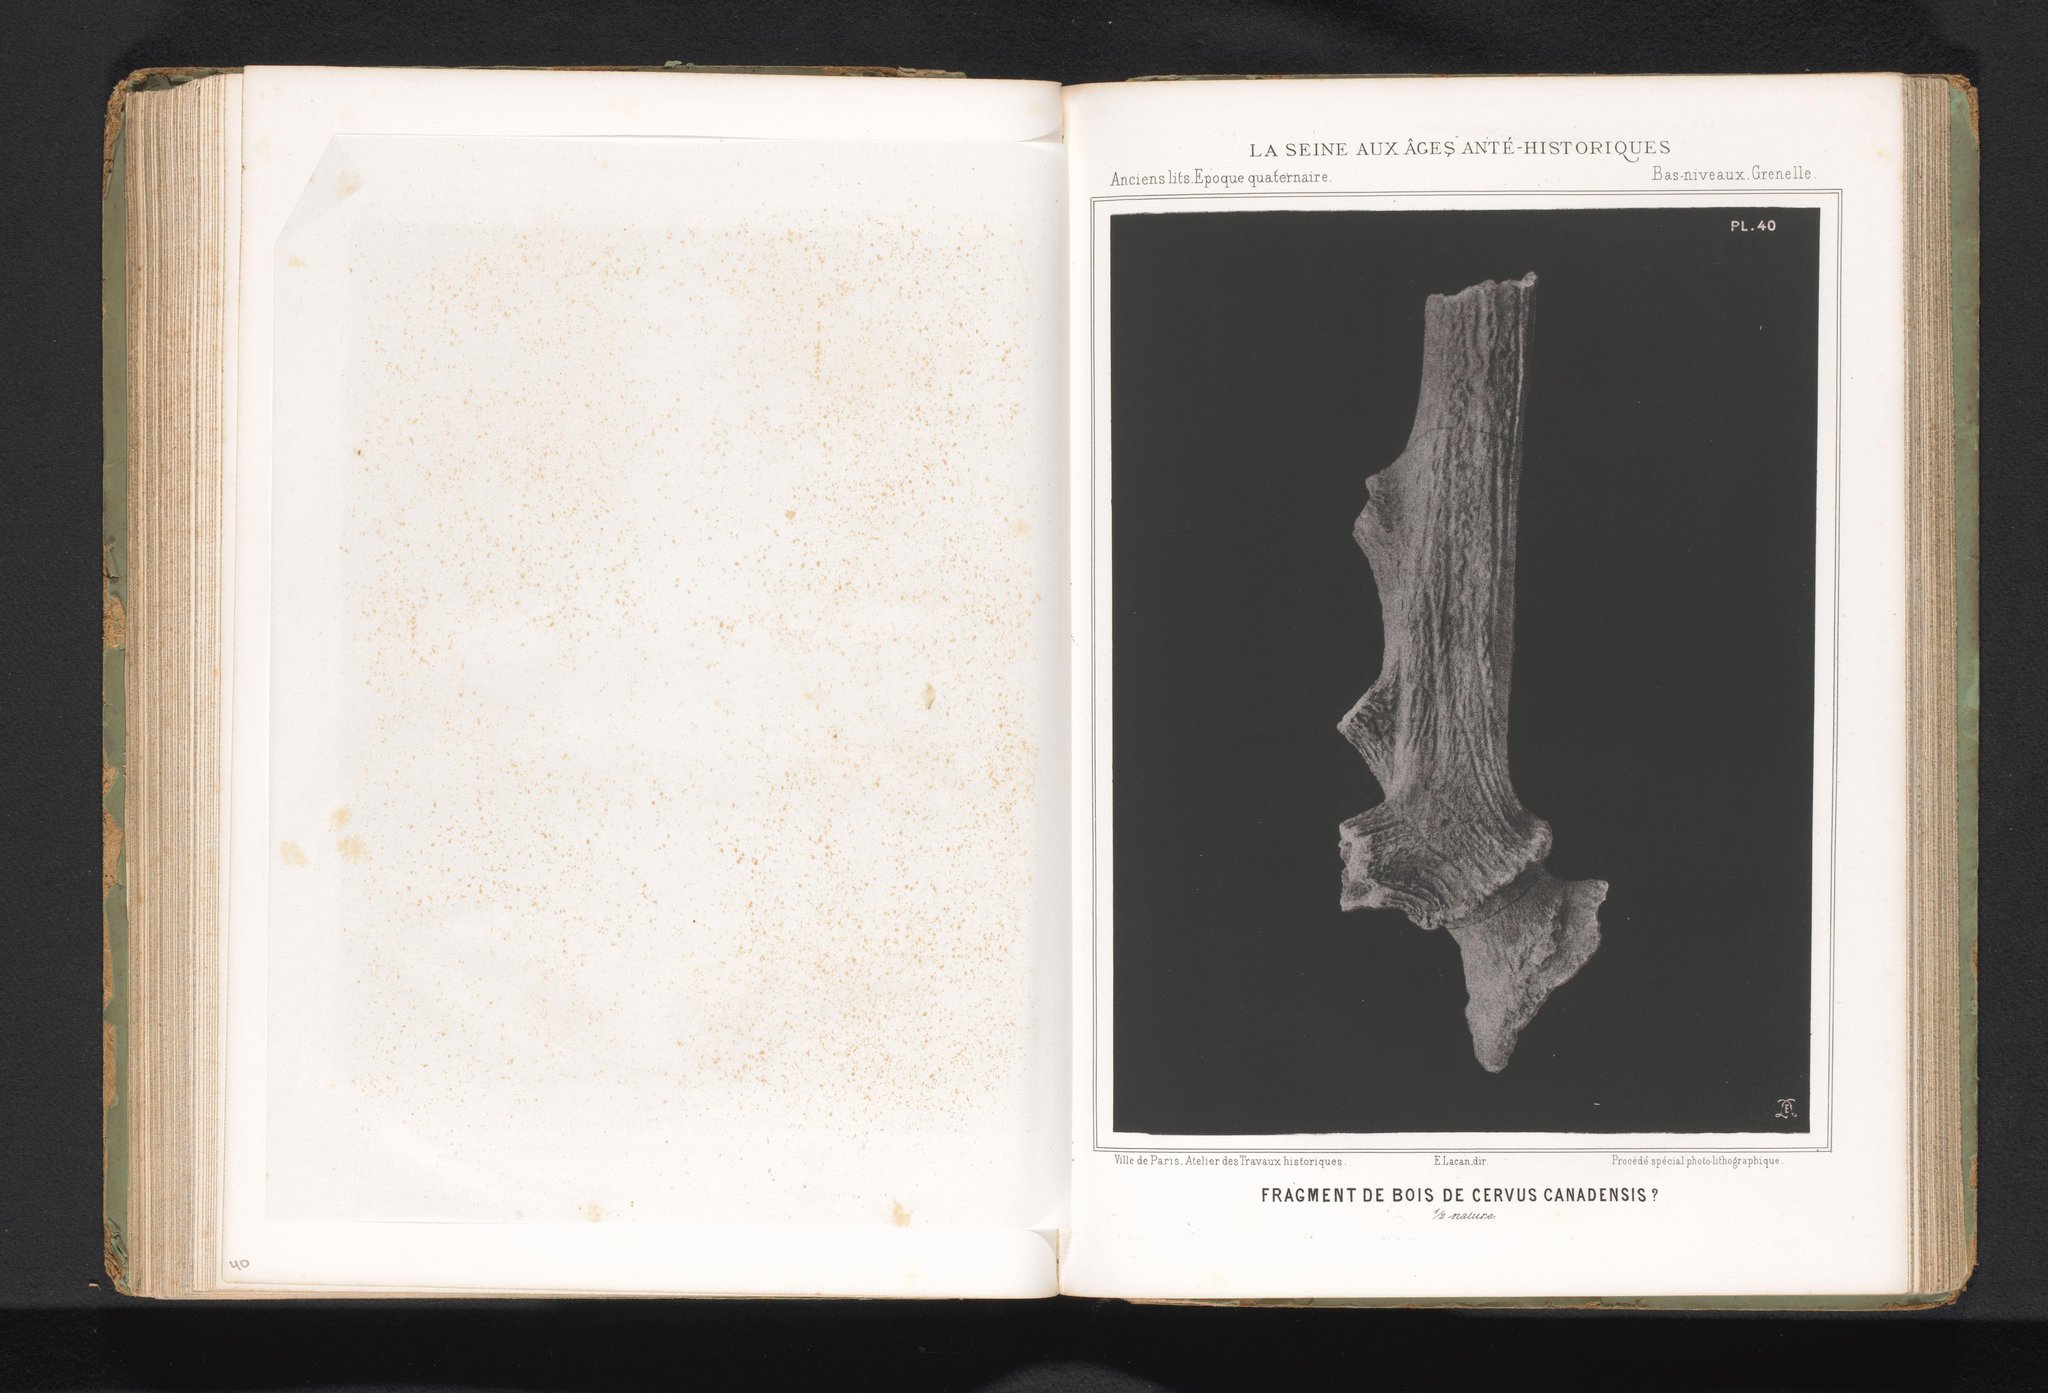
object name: photomechanical print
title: Fragment de bois de Cervus canadensis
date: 1864-1869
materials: paper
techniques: photolithography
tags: animals (+ skeleton of an animal), palaeontology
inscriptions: monogram: ‘E’, inscription: ‘Procédé spécial photo-lithographique’, inscription: ‘1/2 nature’, inscription: ‘PL. 40’